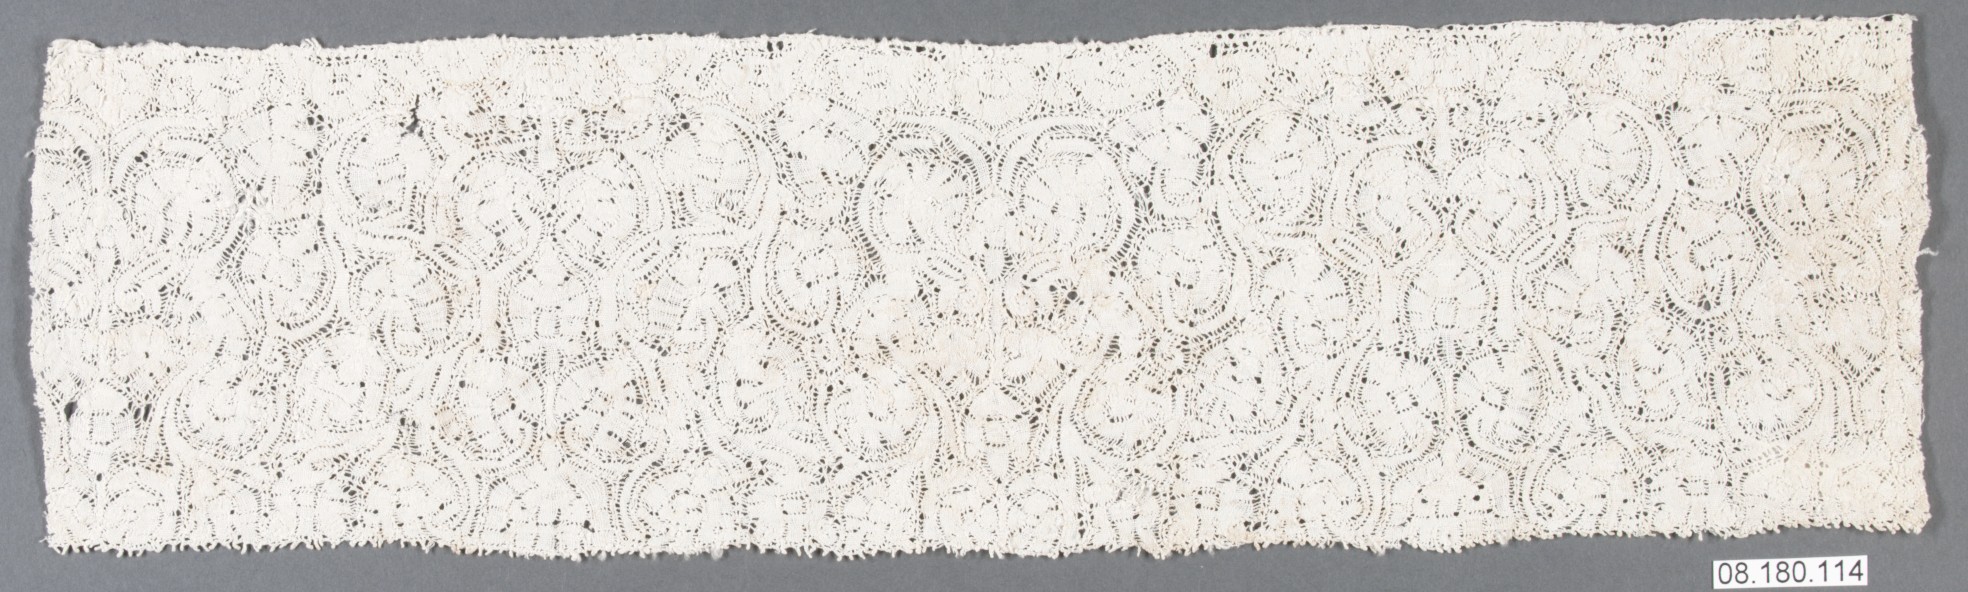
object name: fragment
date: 1601-1700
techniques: lace